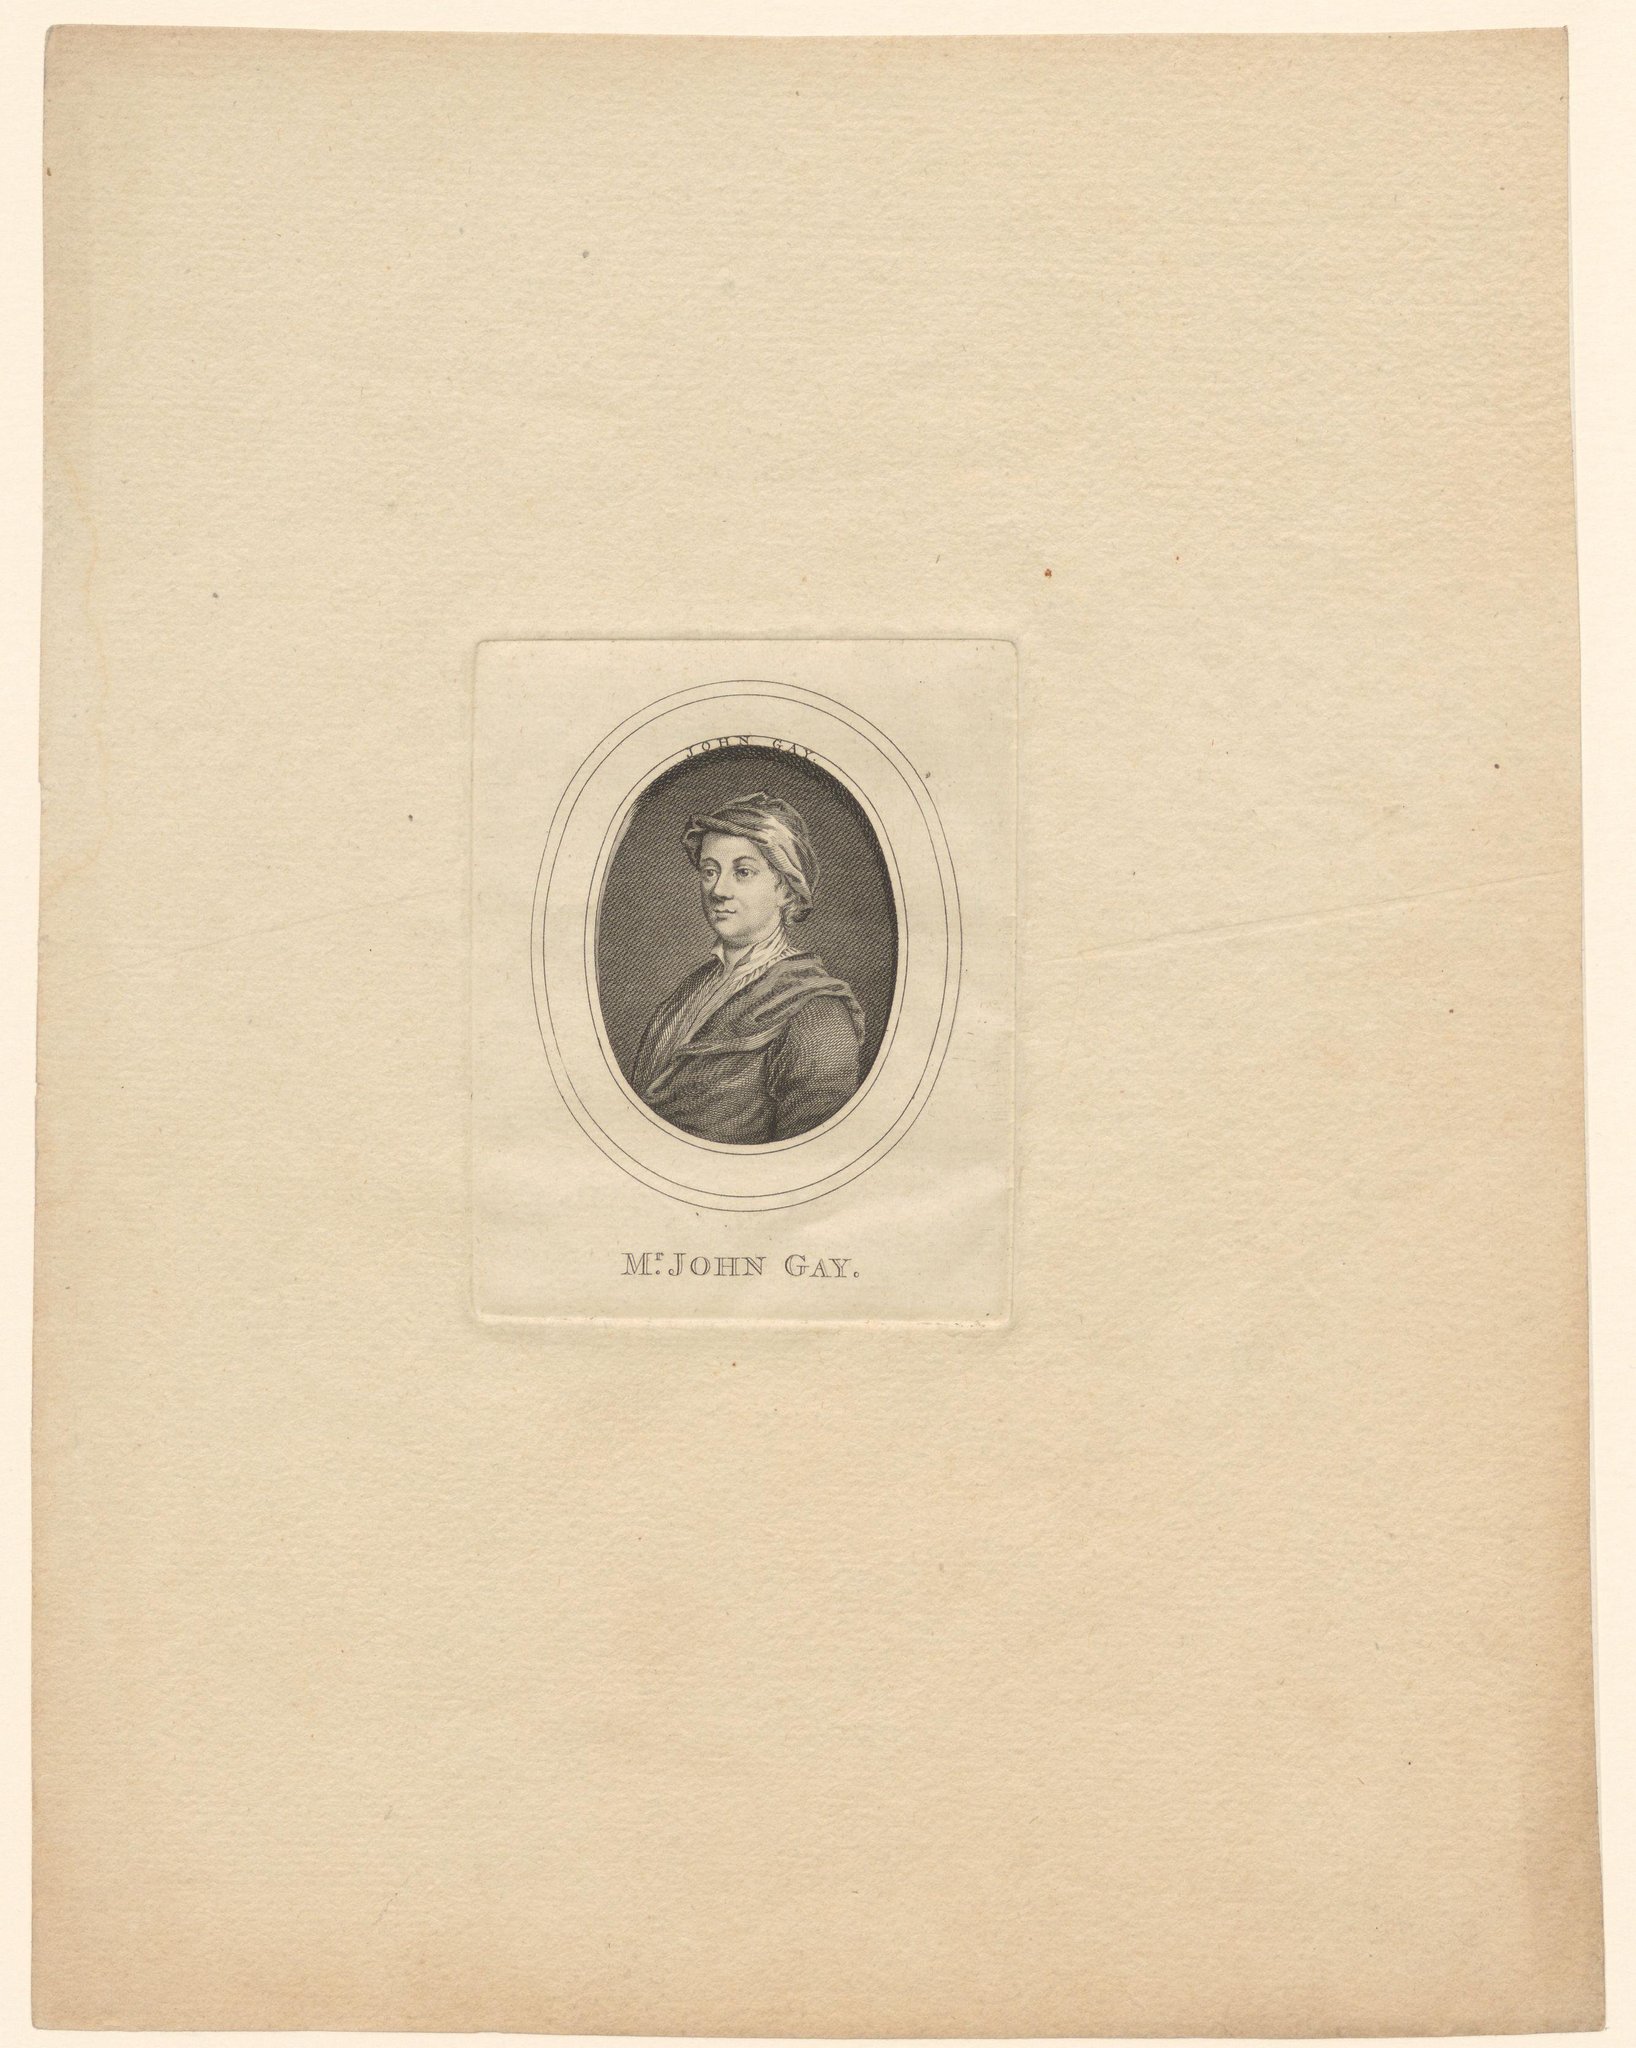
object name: print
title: Portret van John Gay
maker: william walker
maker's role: print maker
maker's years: 1729-1793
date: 1739-1793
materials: paper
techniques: engraving, etching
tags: director, producer ~ the stage, historical persons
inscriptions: collector's mark: Lugt 2228